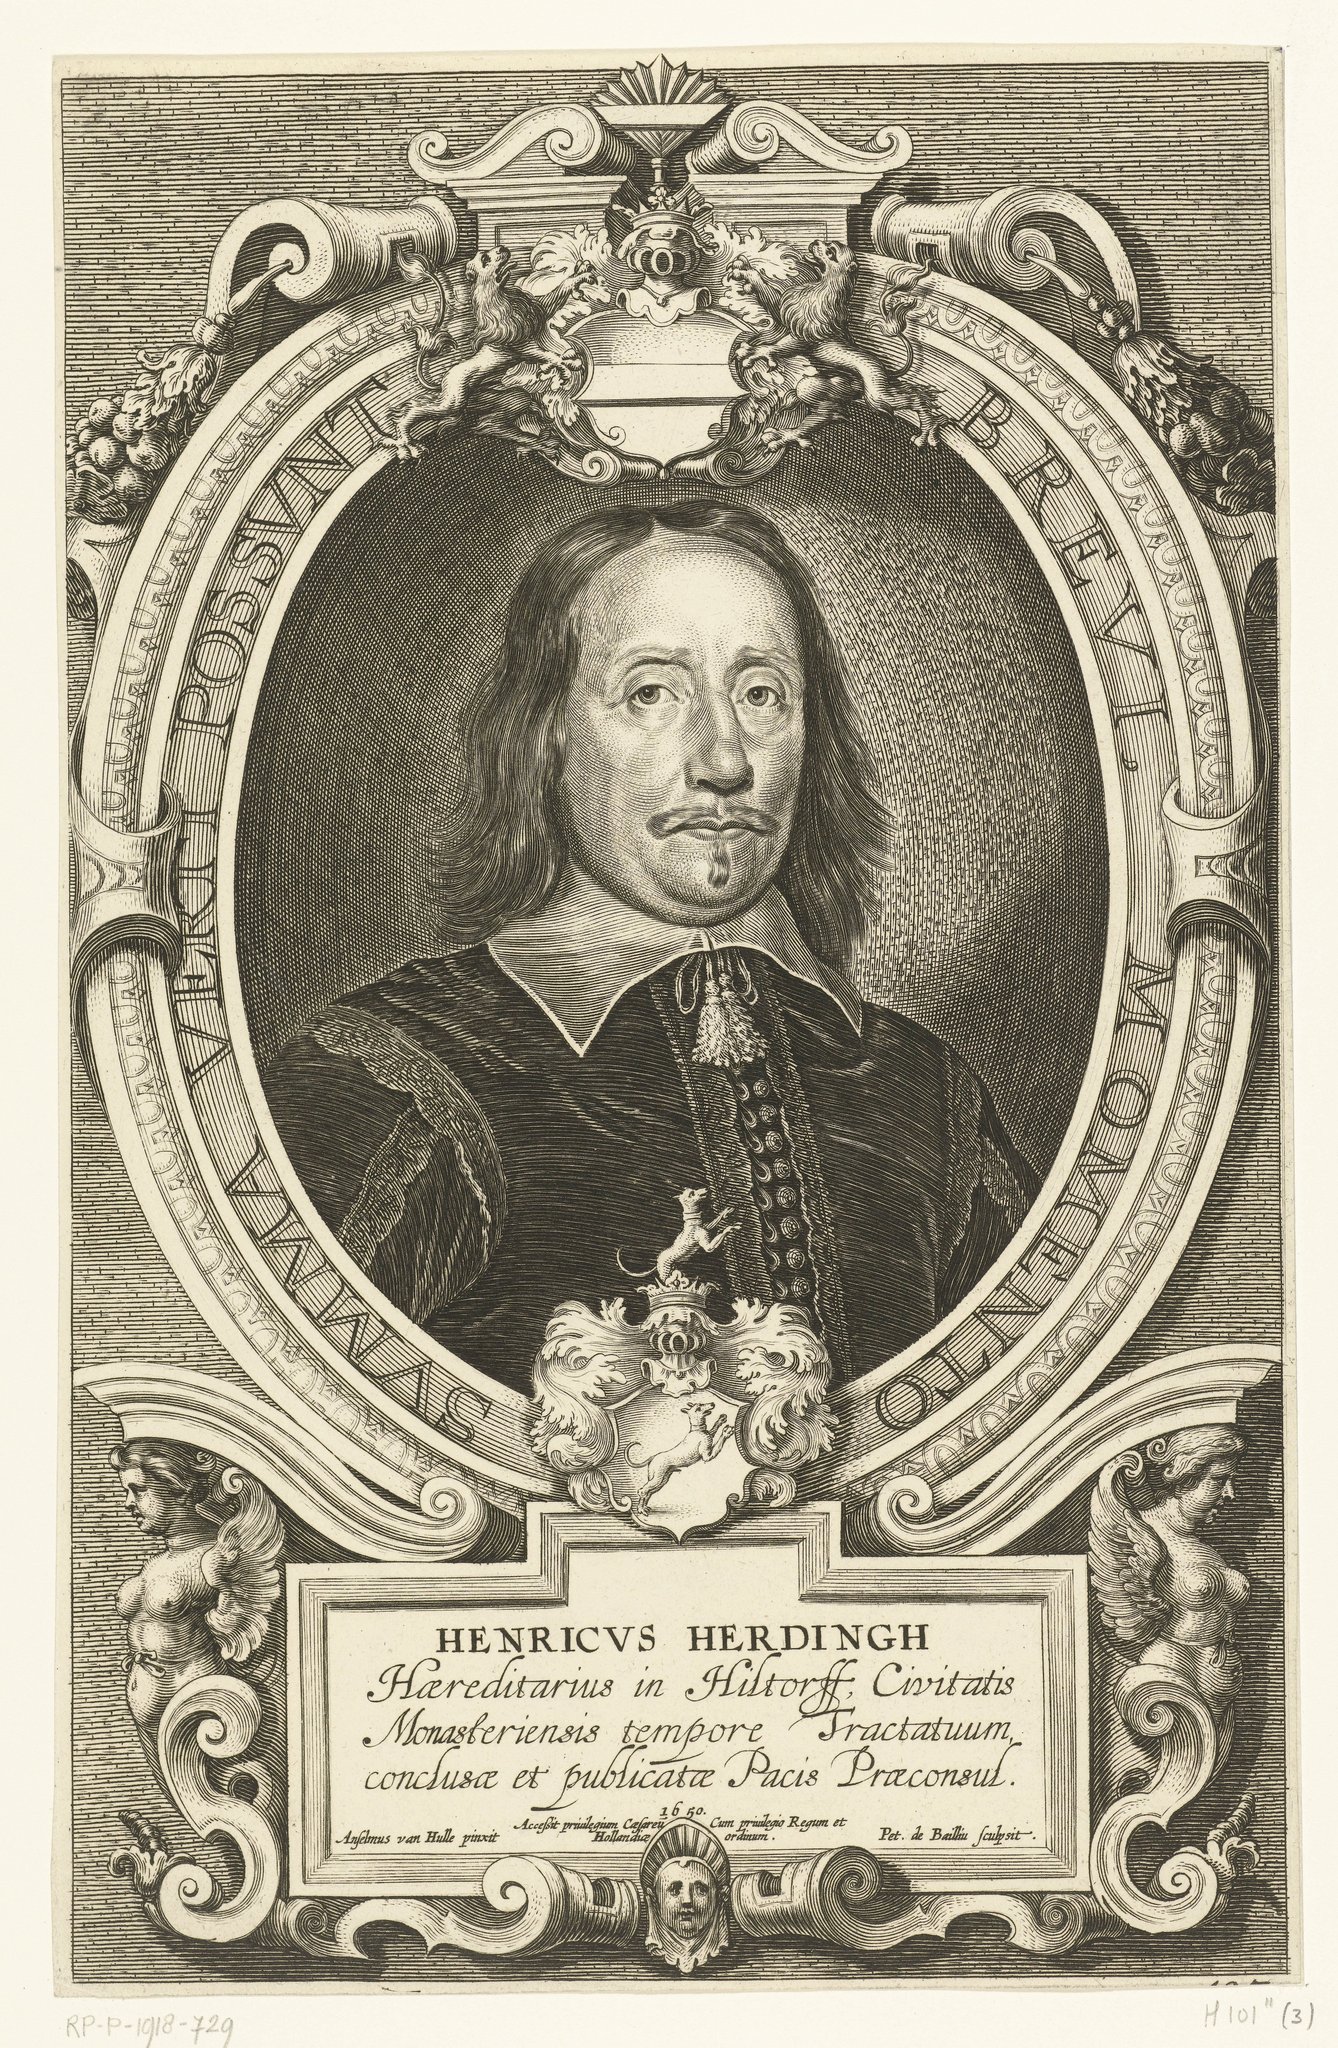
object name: print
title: Henricus Herdingh Haereditarius (...) publicatae pacis praeconsul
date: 1650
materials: paper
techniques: engraving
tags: henricus herdingh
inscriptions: collector's mark: Lugt 2233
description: Portret van Henricus Herdingh in ovale omlijsting met opschrift Brevl momento summa verti possvnt.